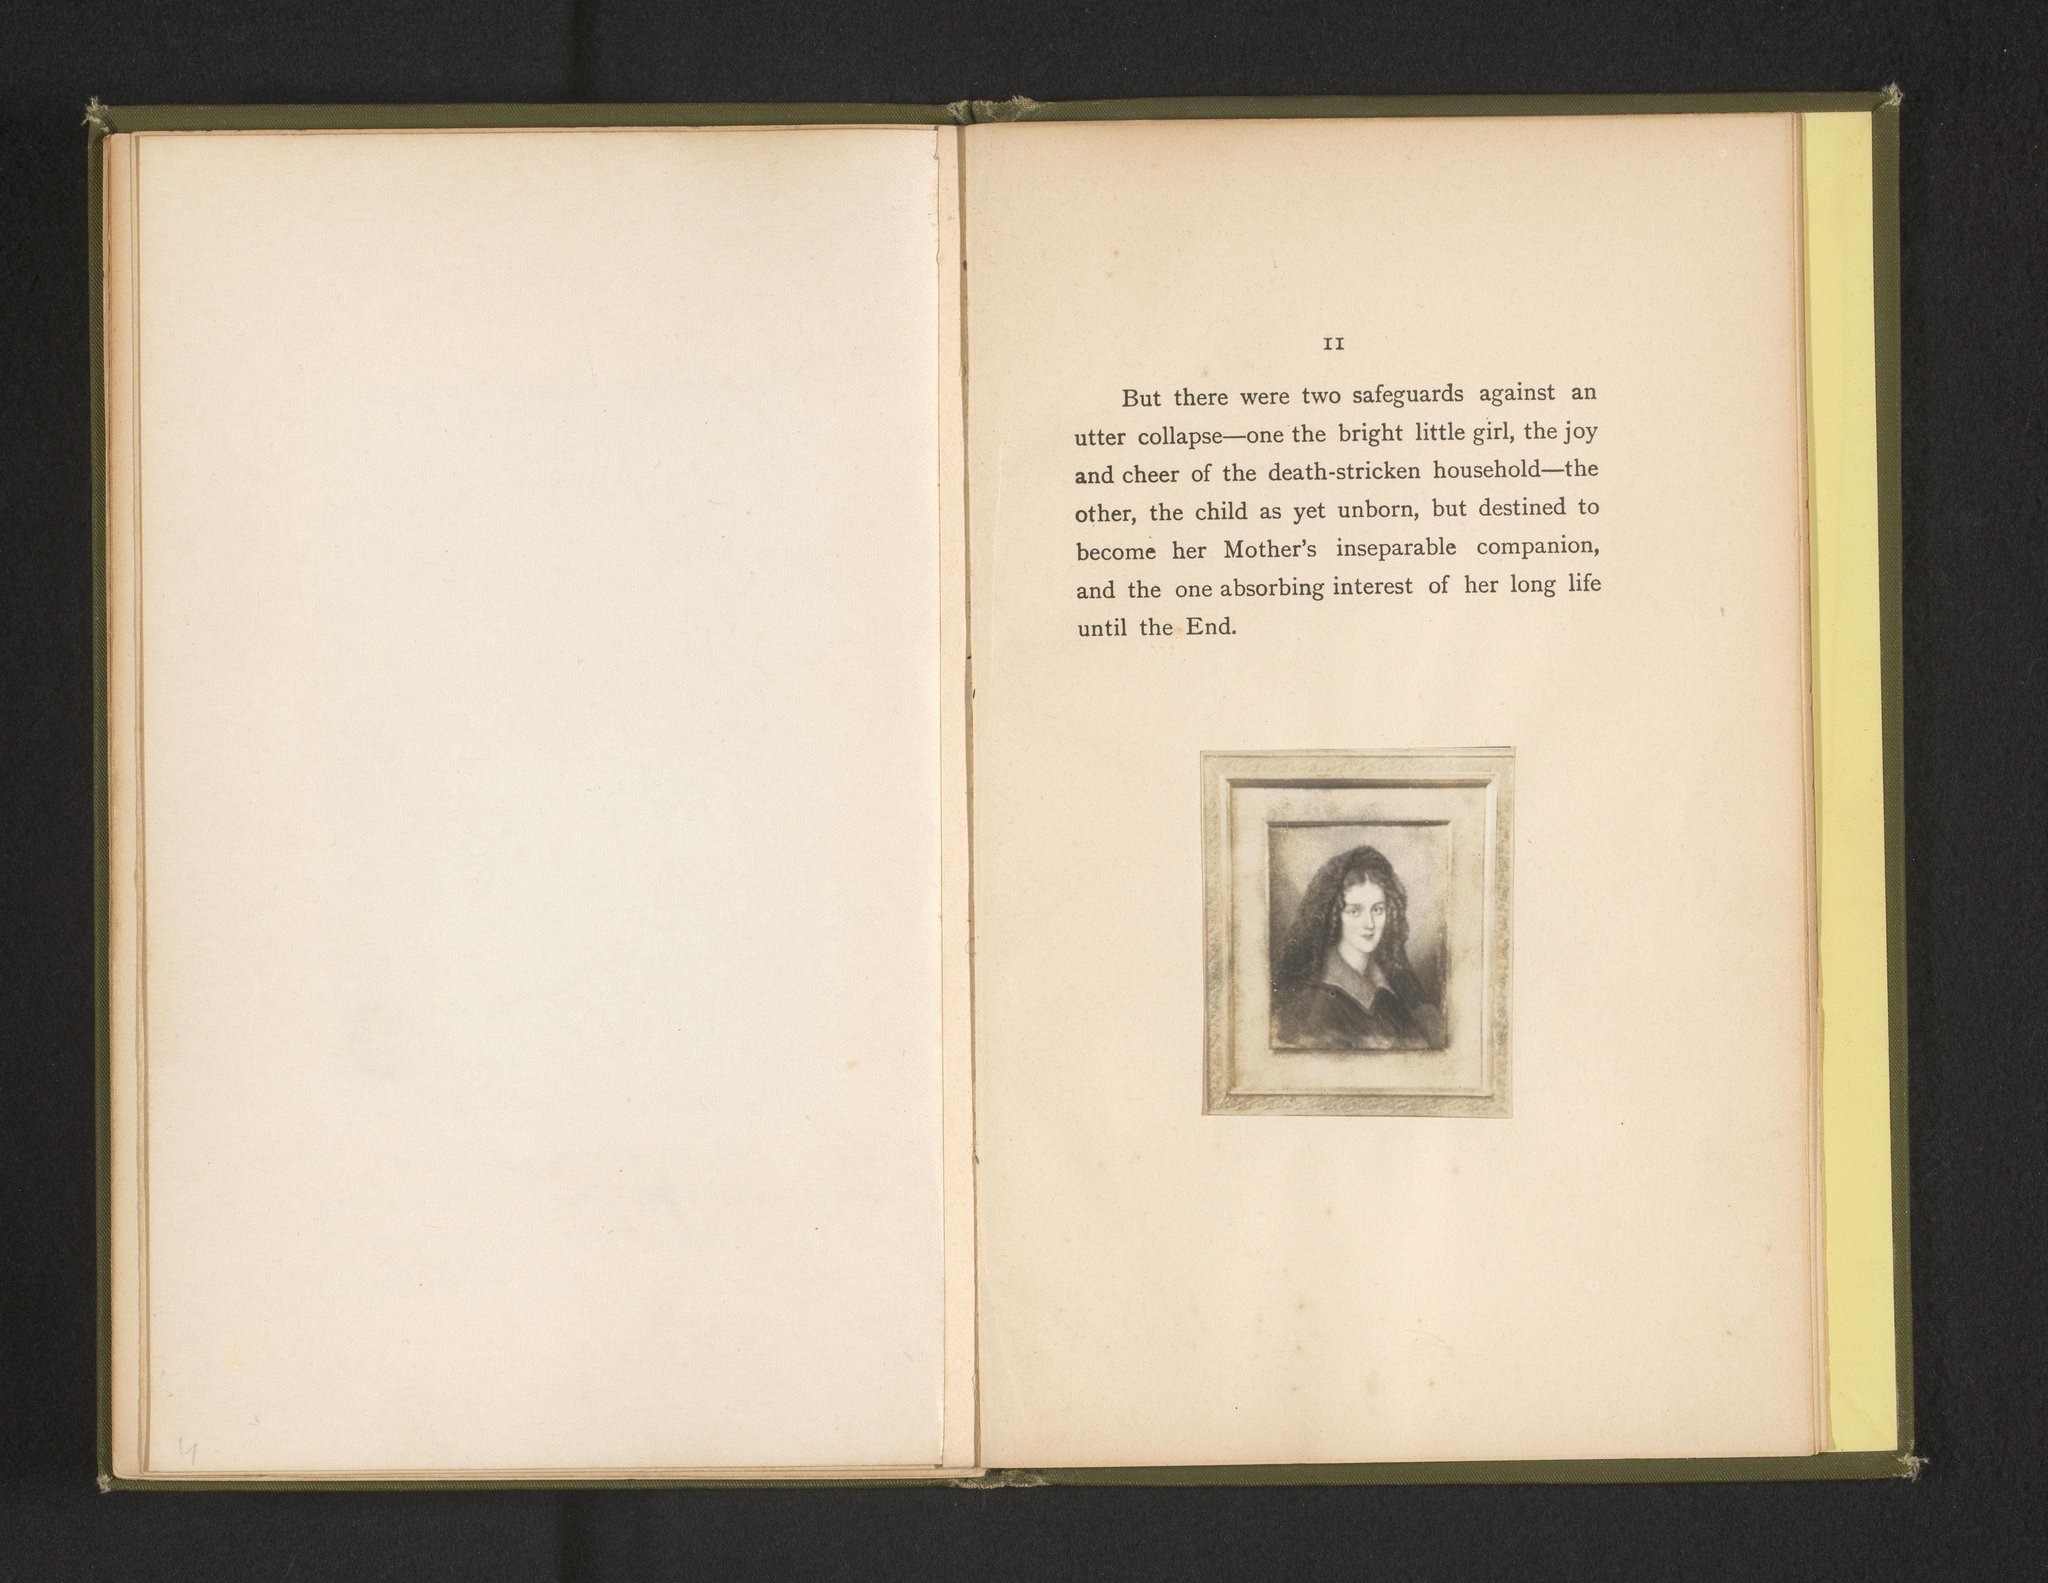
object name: reproduction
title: Fotoreproductie van een schilderij, (vermoedelijk) voorstellende een portret van Selina Tollemache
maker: Anonymous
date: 1890-1900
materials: photographic support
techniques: gelatin silver print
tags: historical persons - bb - woman, veil